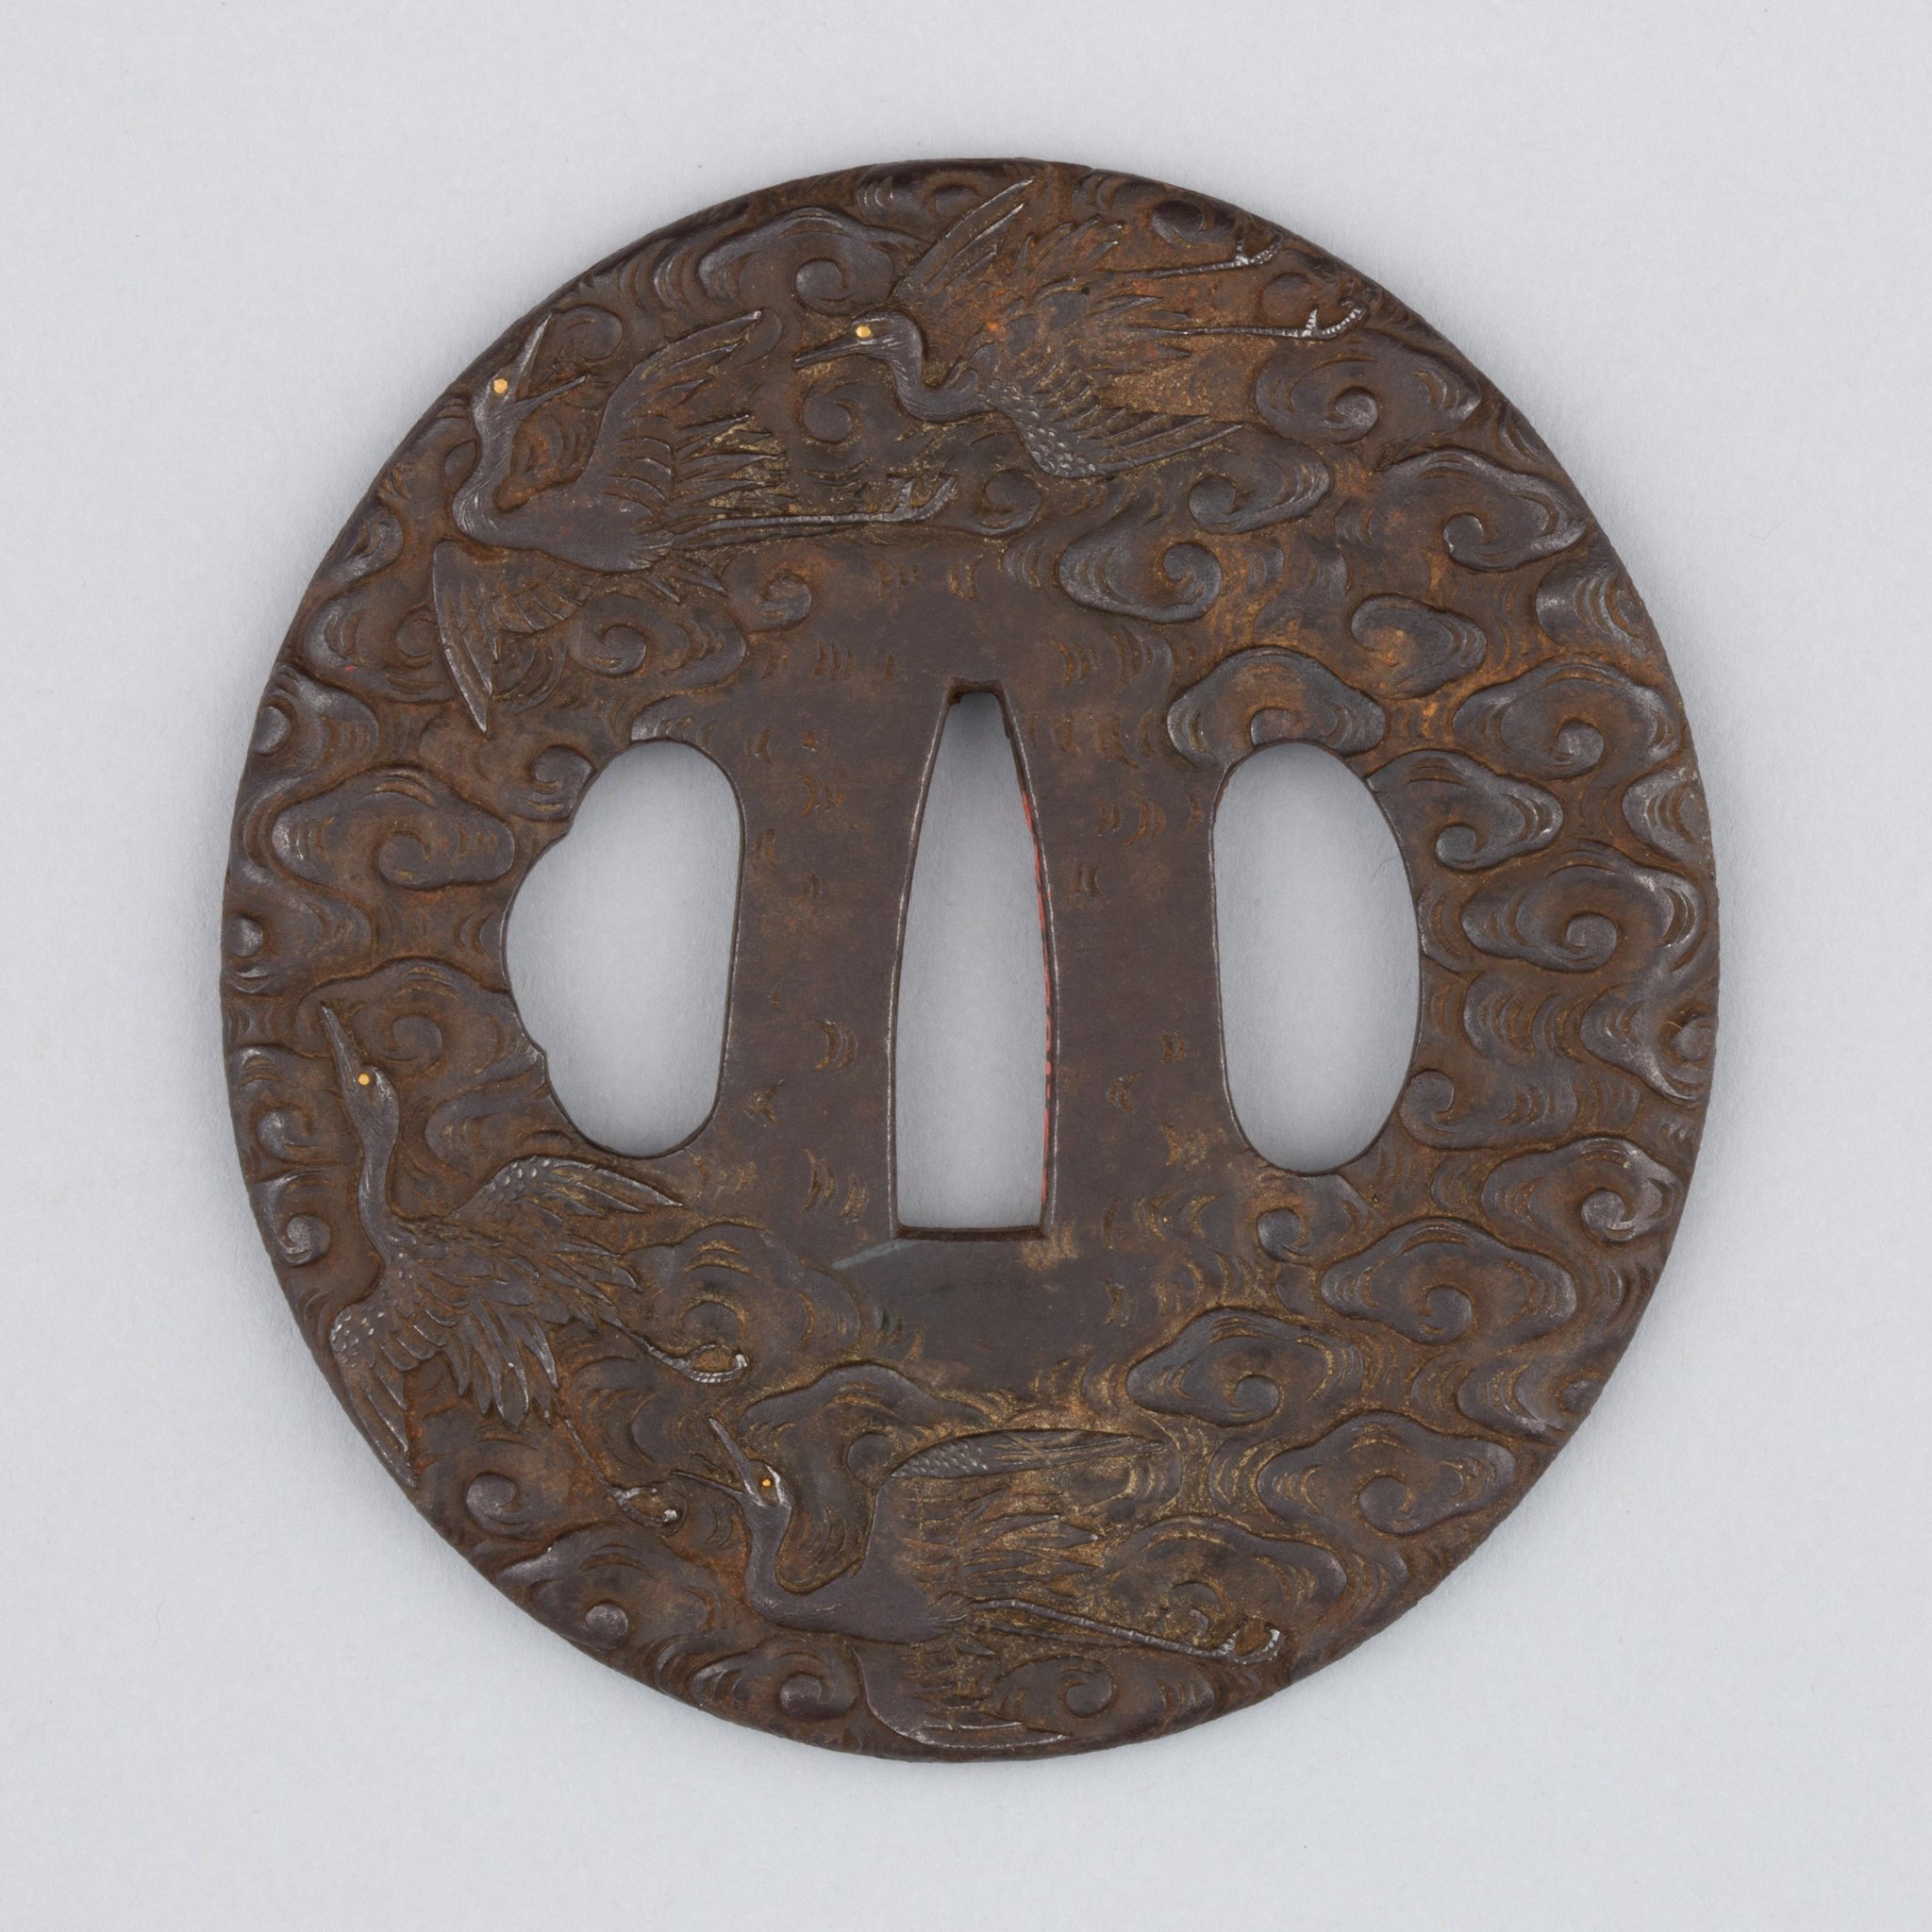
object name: sword guard tsuba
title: Sword Guard (Tsuba)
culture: japanese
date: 1615-1868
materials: copper, gold, iron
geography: japan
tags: birds